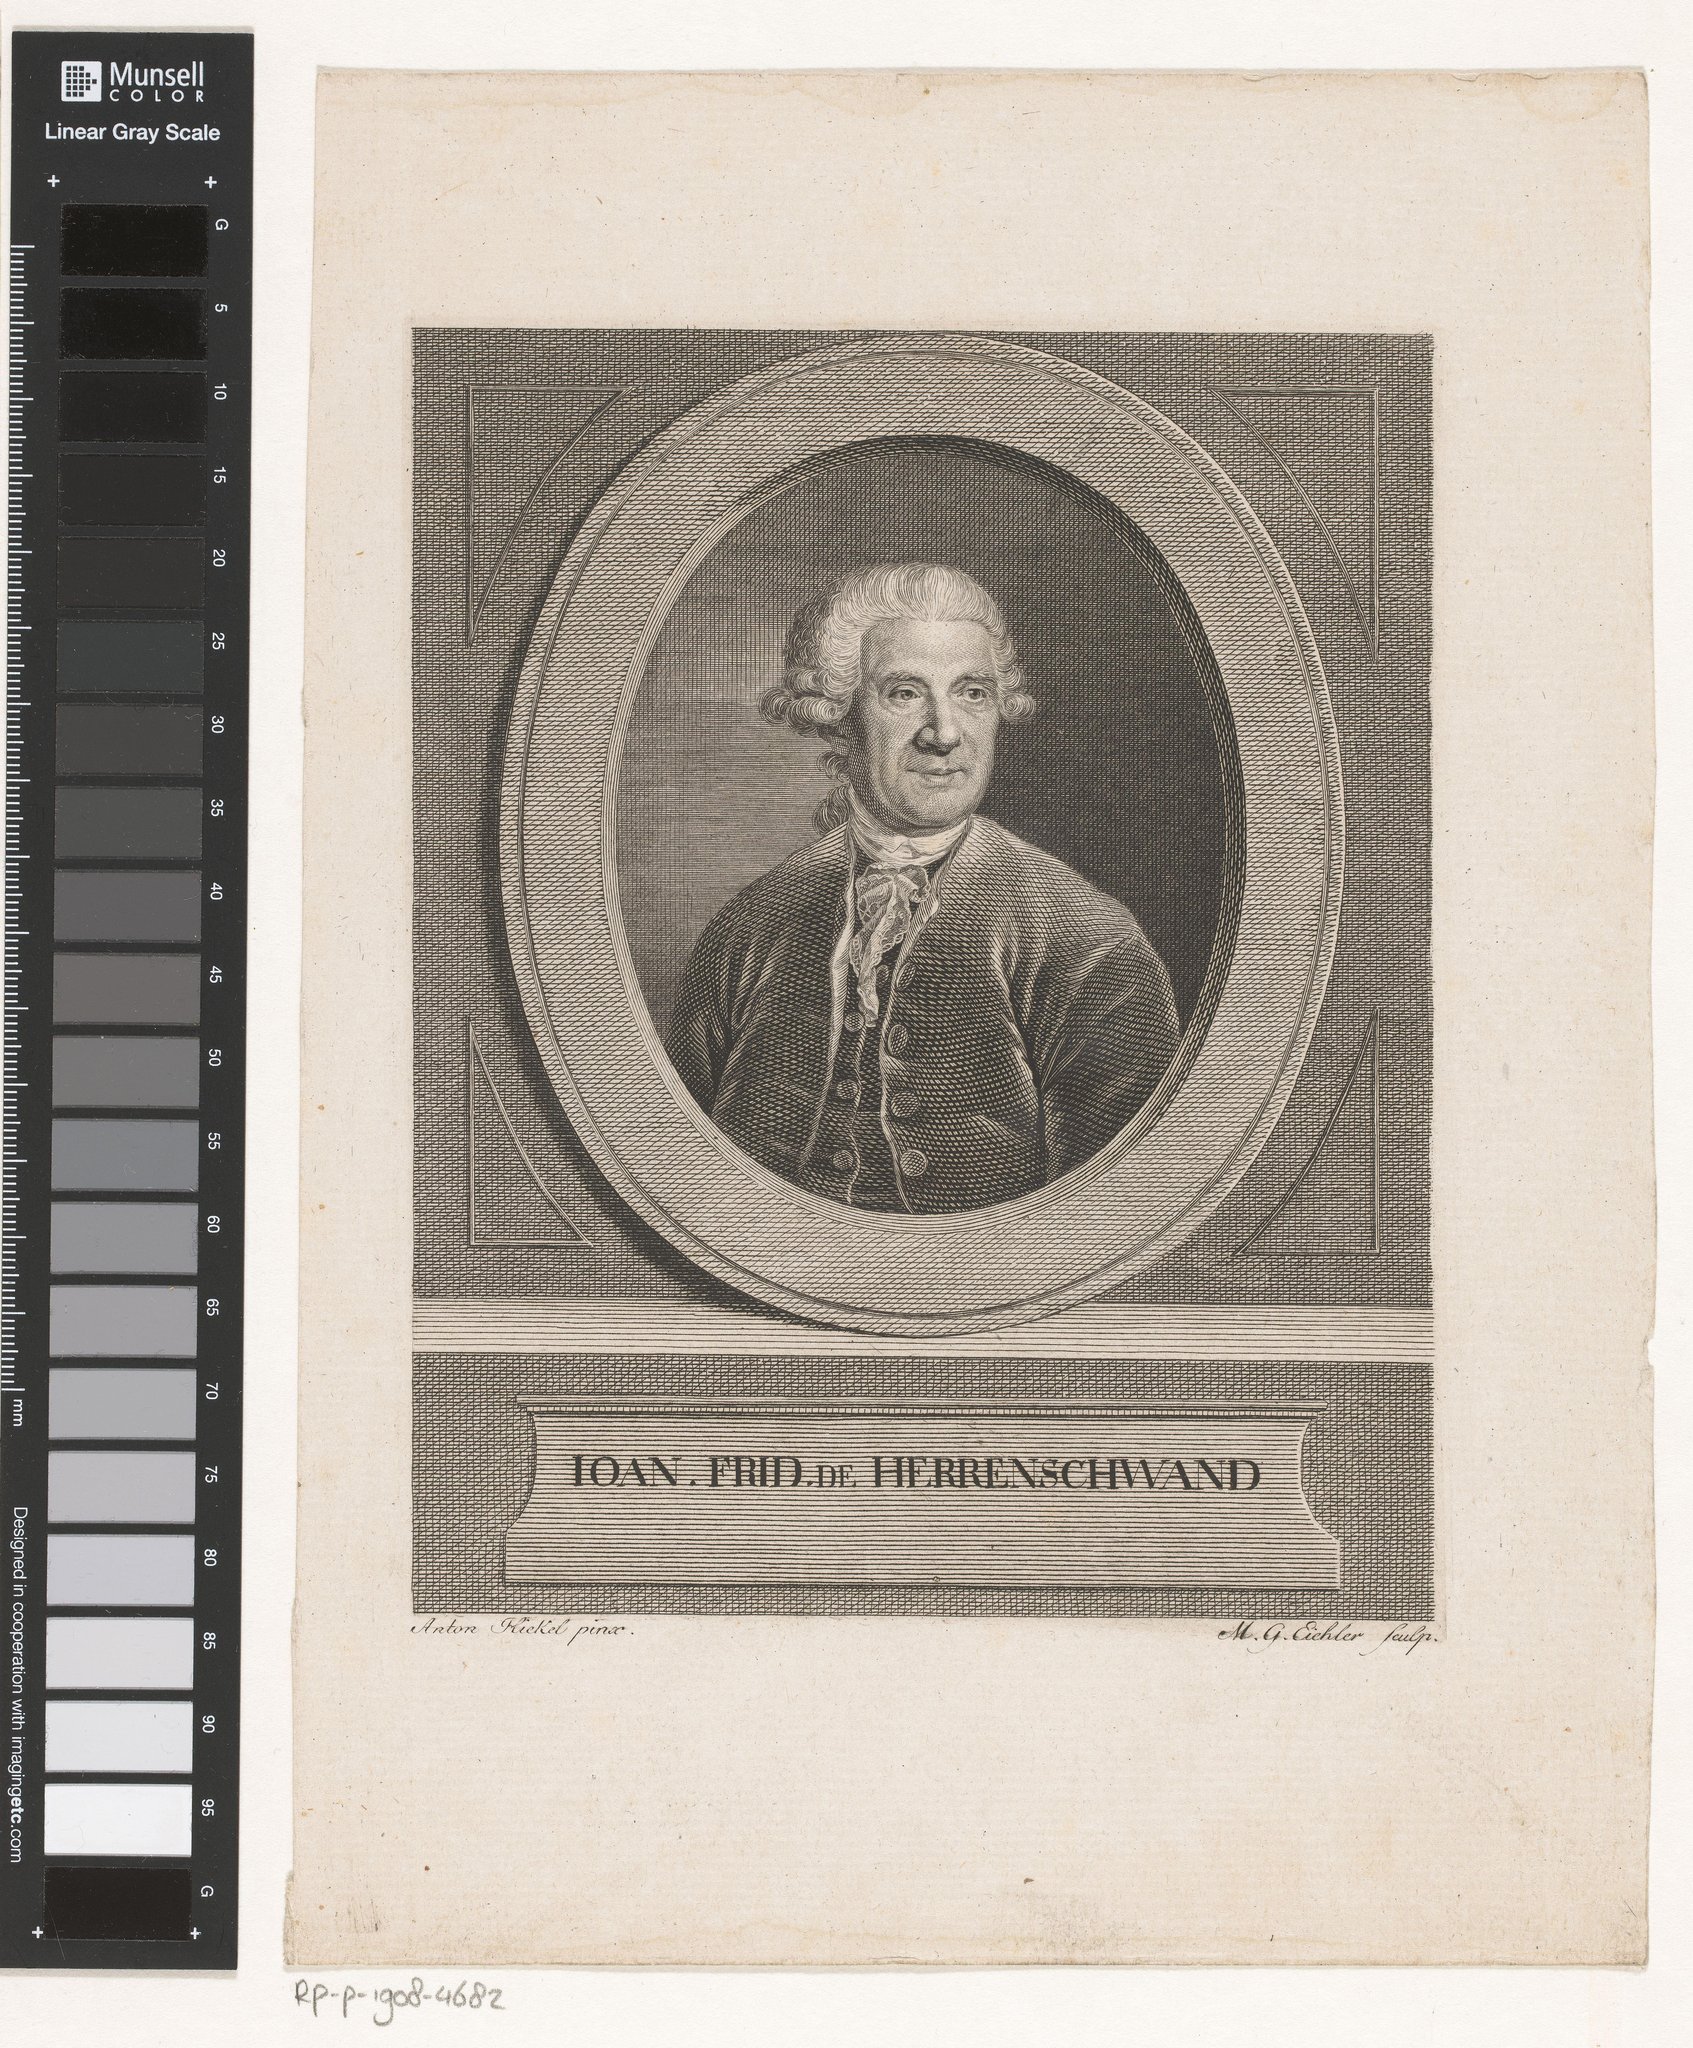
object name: print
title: Portret van Johann Friedrich Herrenschwand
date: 1758-1818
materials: paper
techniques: engraving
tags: historical persons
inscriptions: collector's mark: Lugt 2228